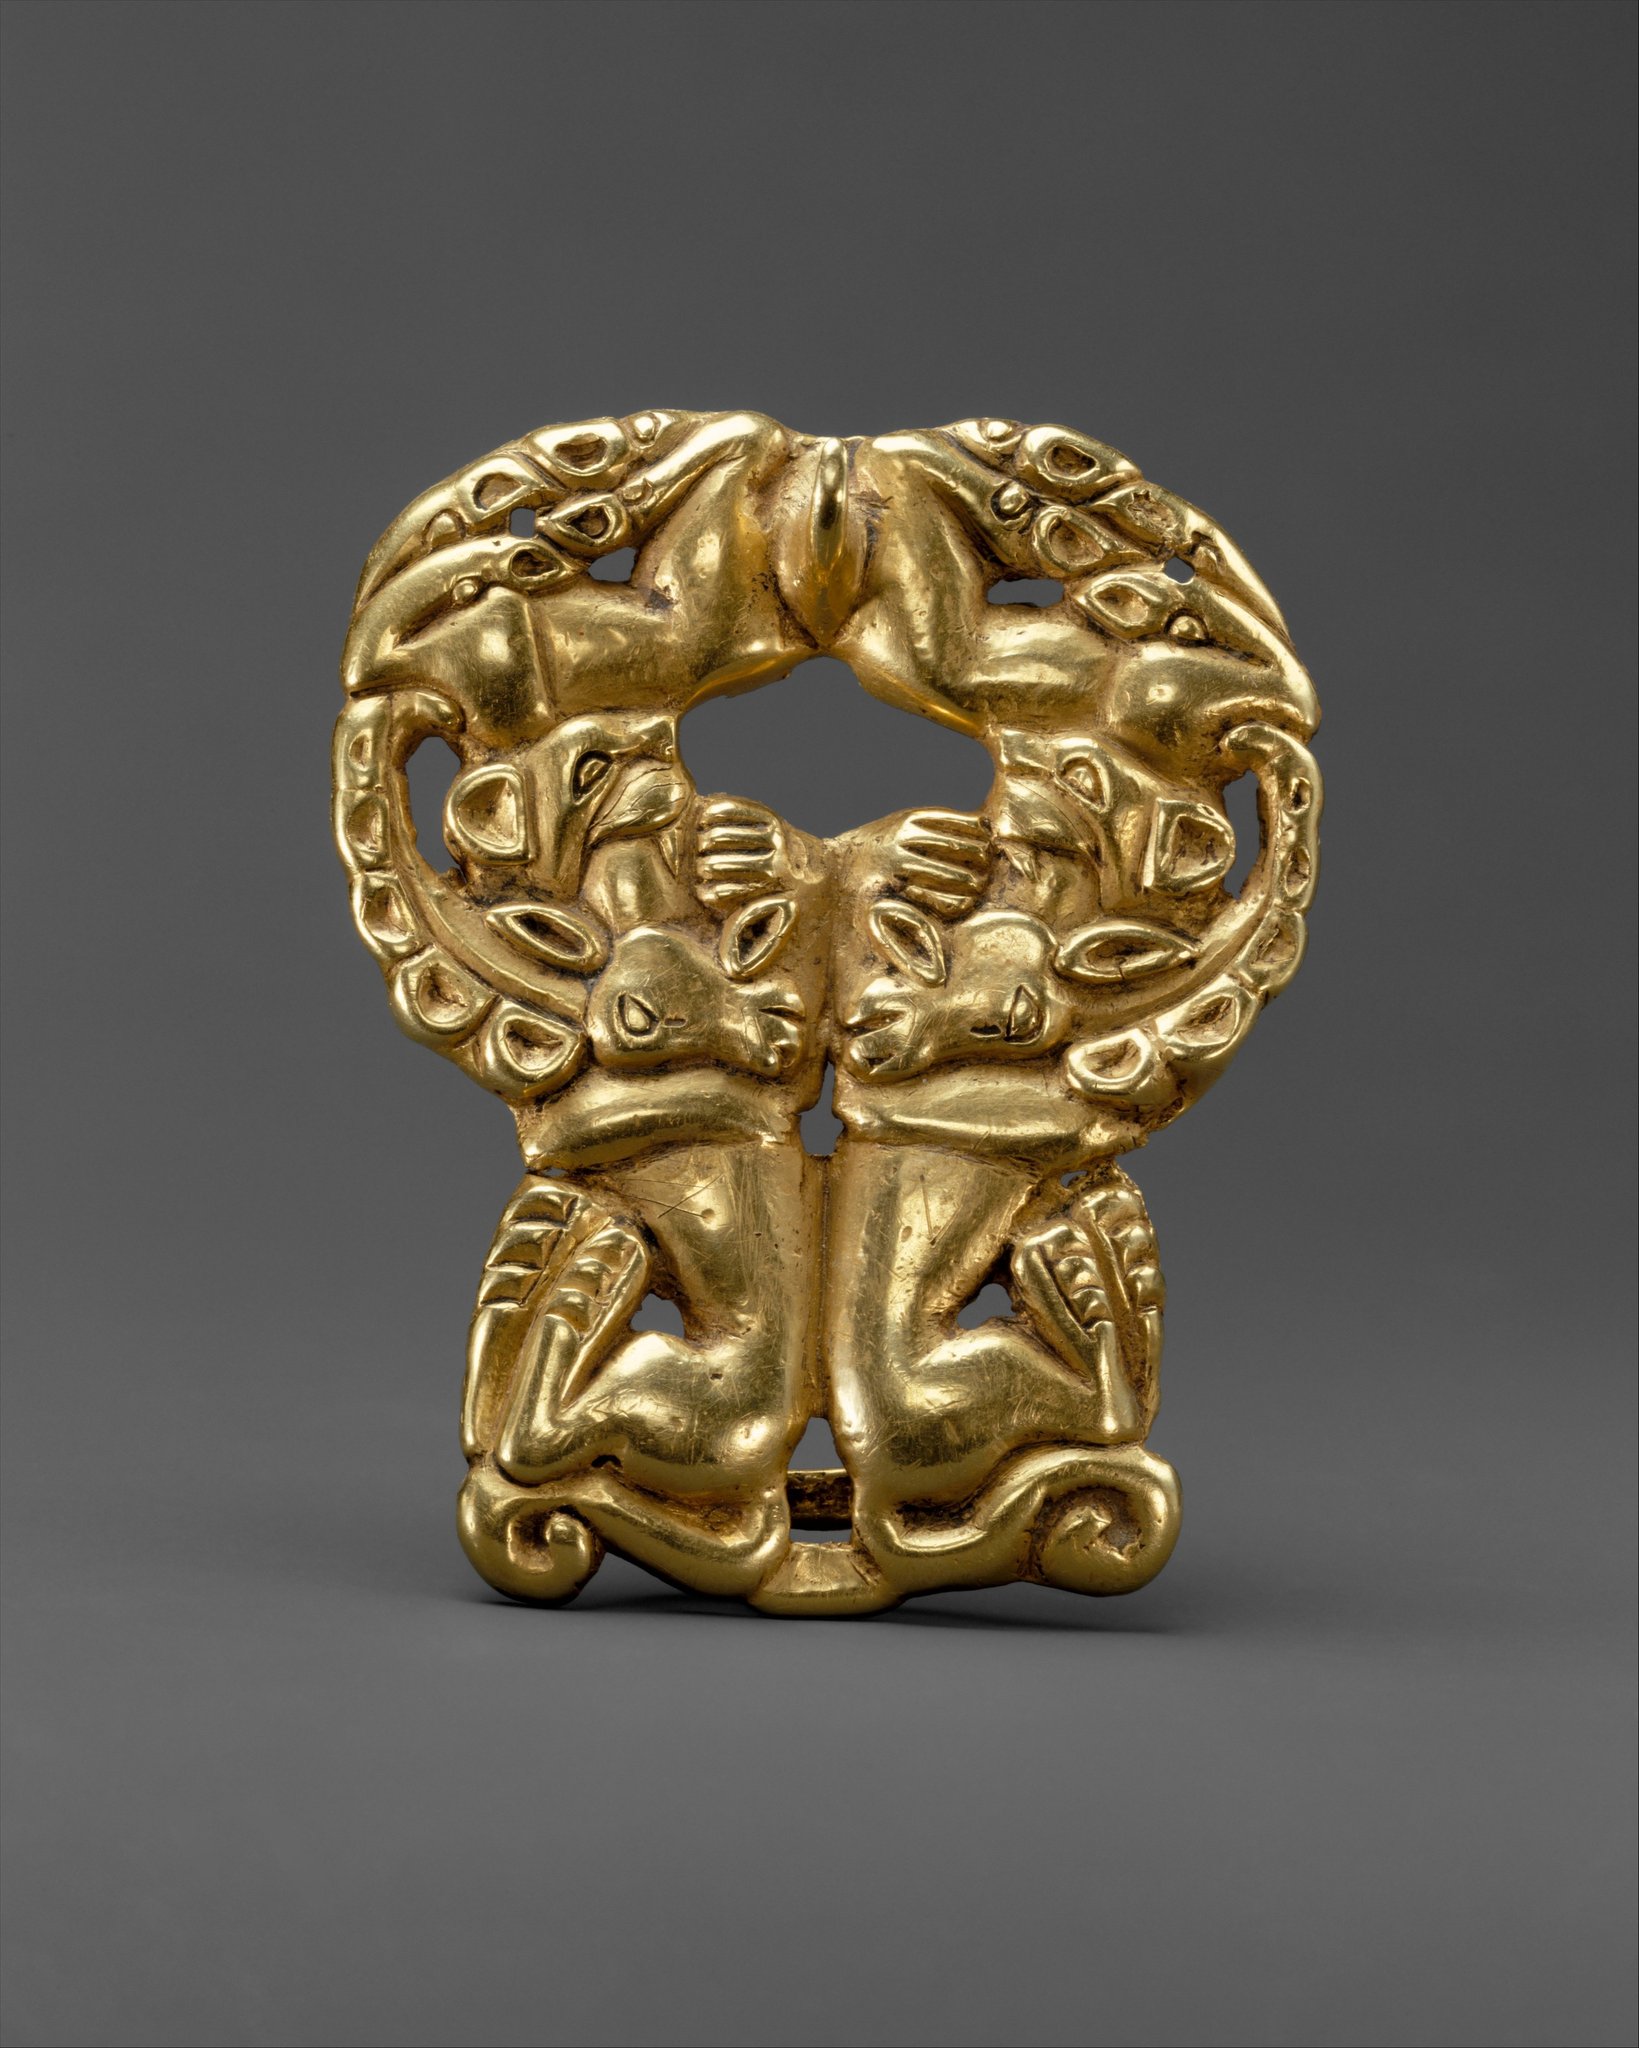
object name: belt buckle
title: Belt buckle with paired felines attacking ibexes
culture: xiongnu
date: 300-101 BCE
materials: gold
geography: mongolia or southern siberia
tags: animals,ibex